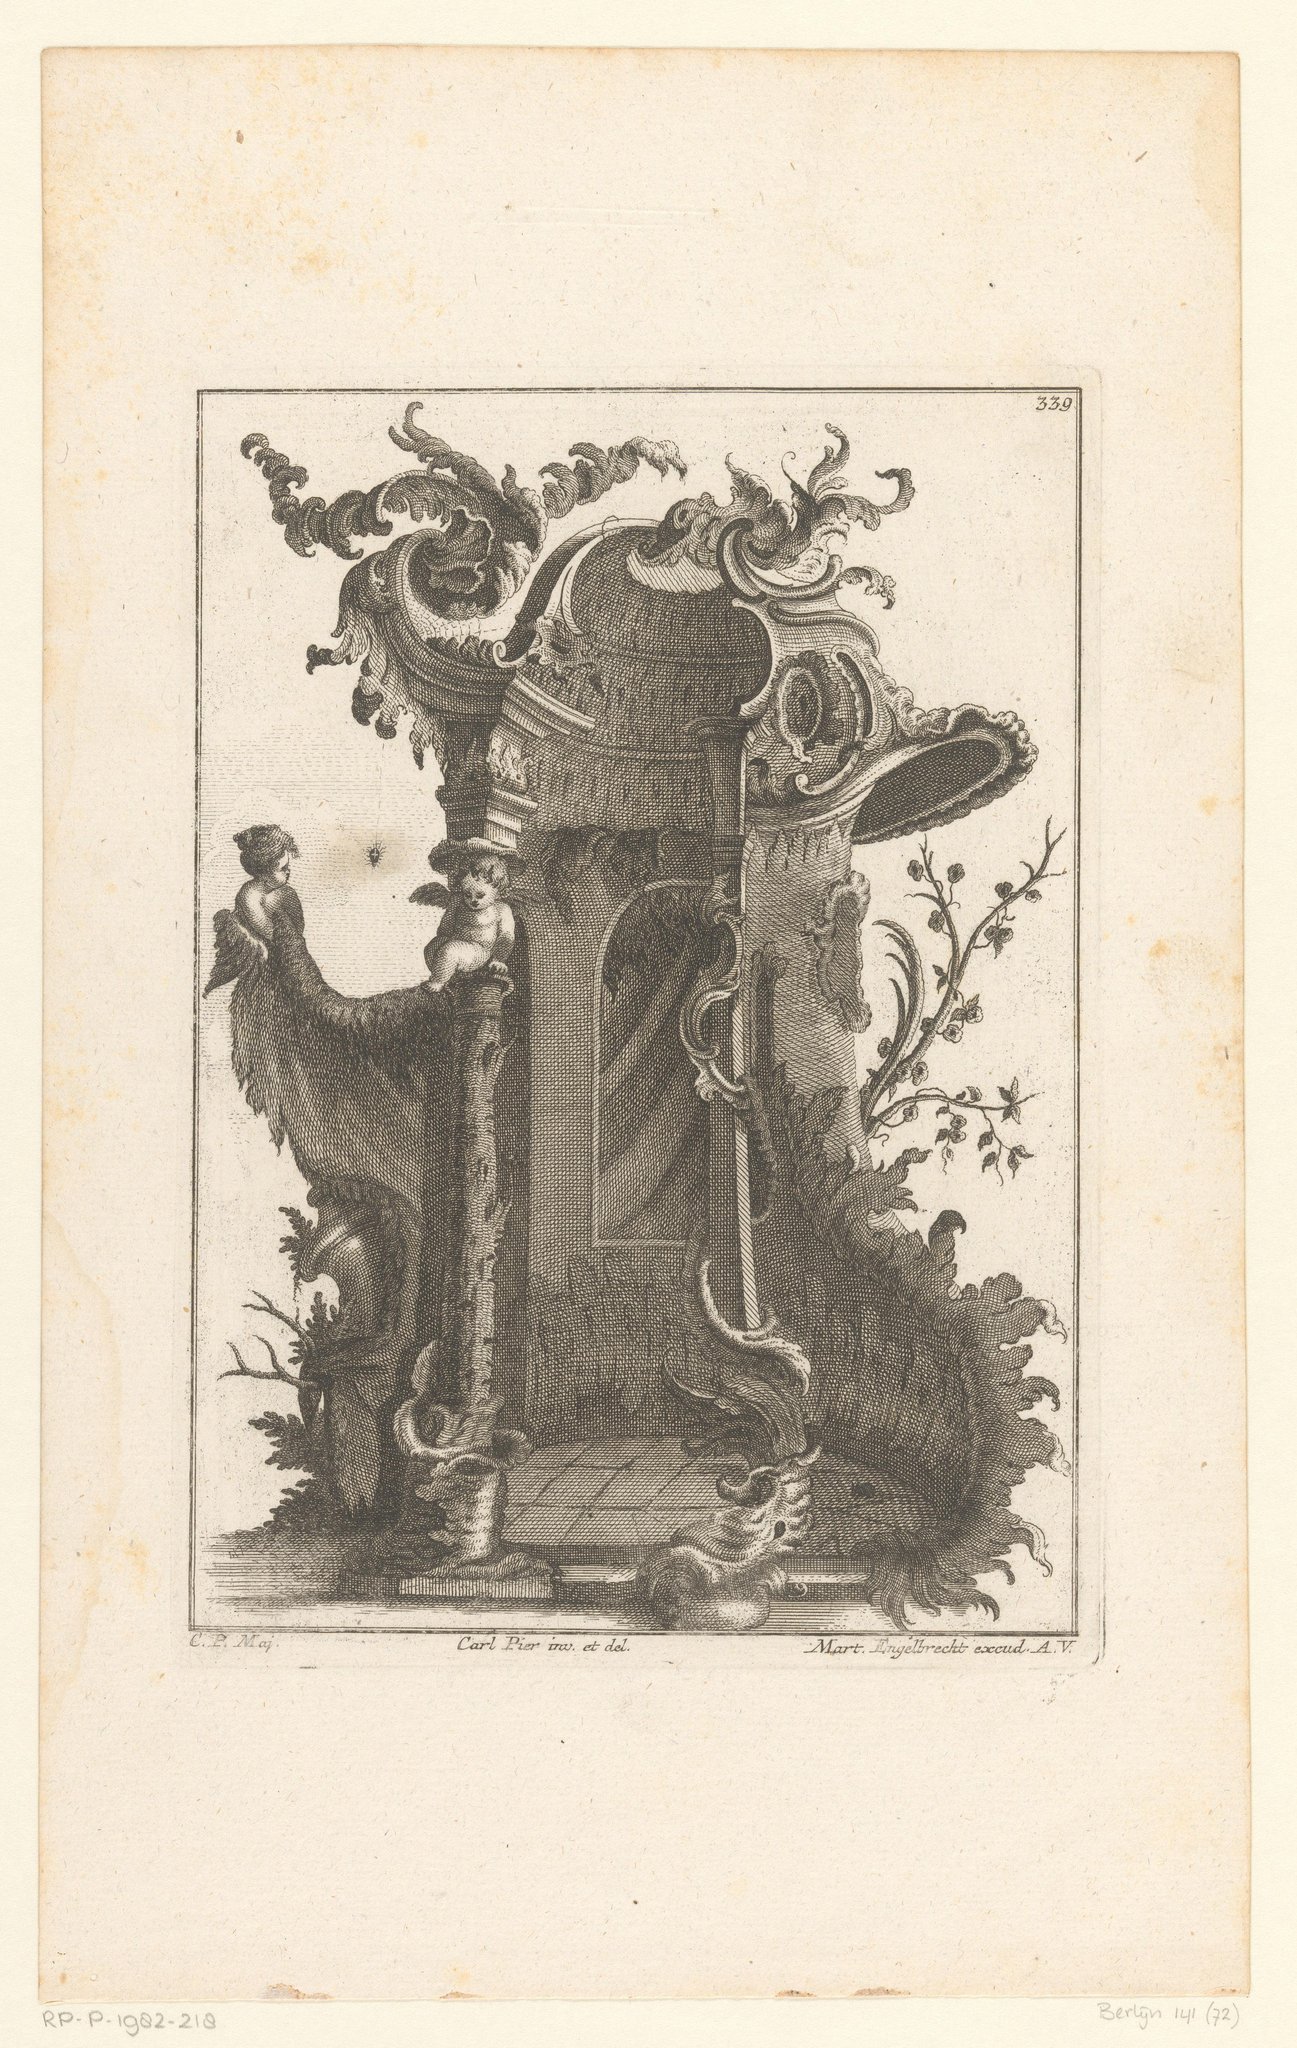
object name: ornament print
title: Bouwwerken met putti en dieren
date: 1745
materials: paper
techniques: etching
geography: augsburg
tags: spiders, fantastic architecture, unrealistic architectural fantasies, cupids: 'amores', 'amoretti', 'putti'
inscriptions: collector's mark: Lugt 2228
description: Rocaille bouwwerk met bladmotieven, twee putti en een spin. In het midden van het bouwwerk is een nis. Prentnummer 339.